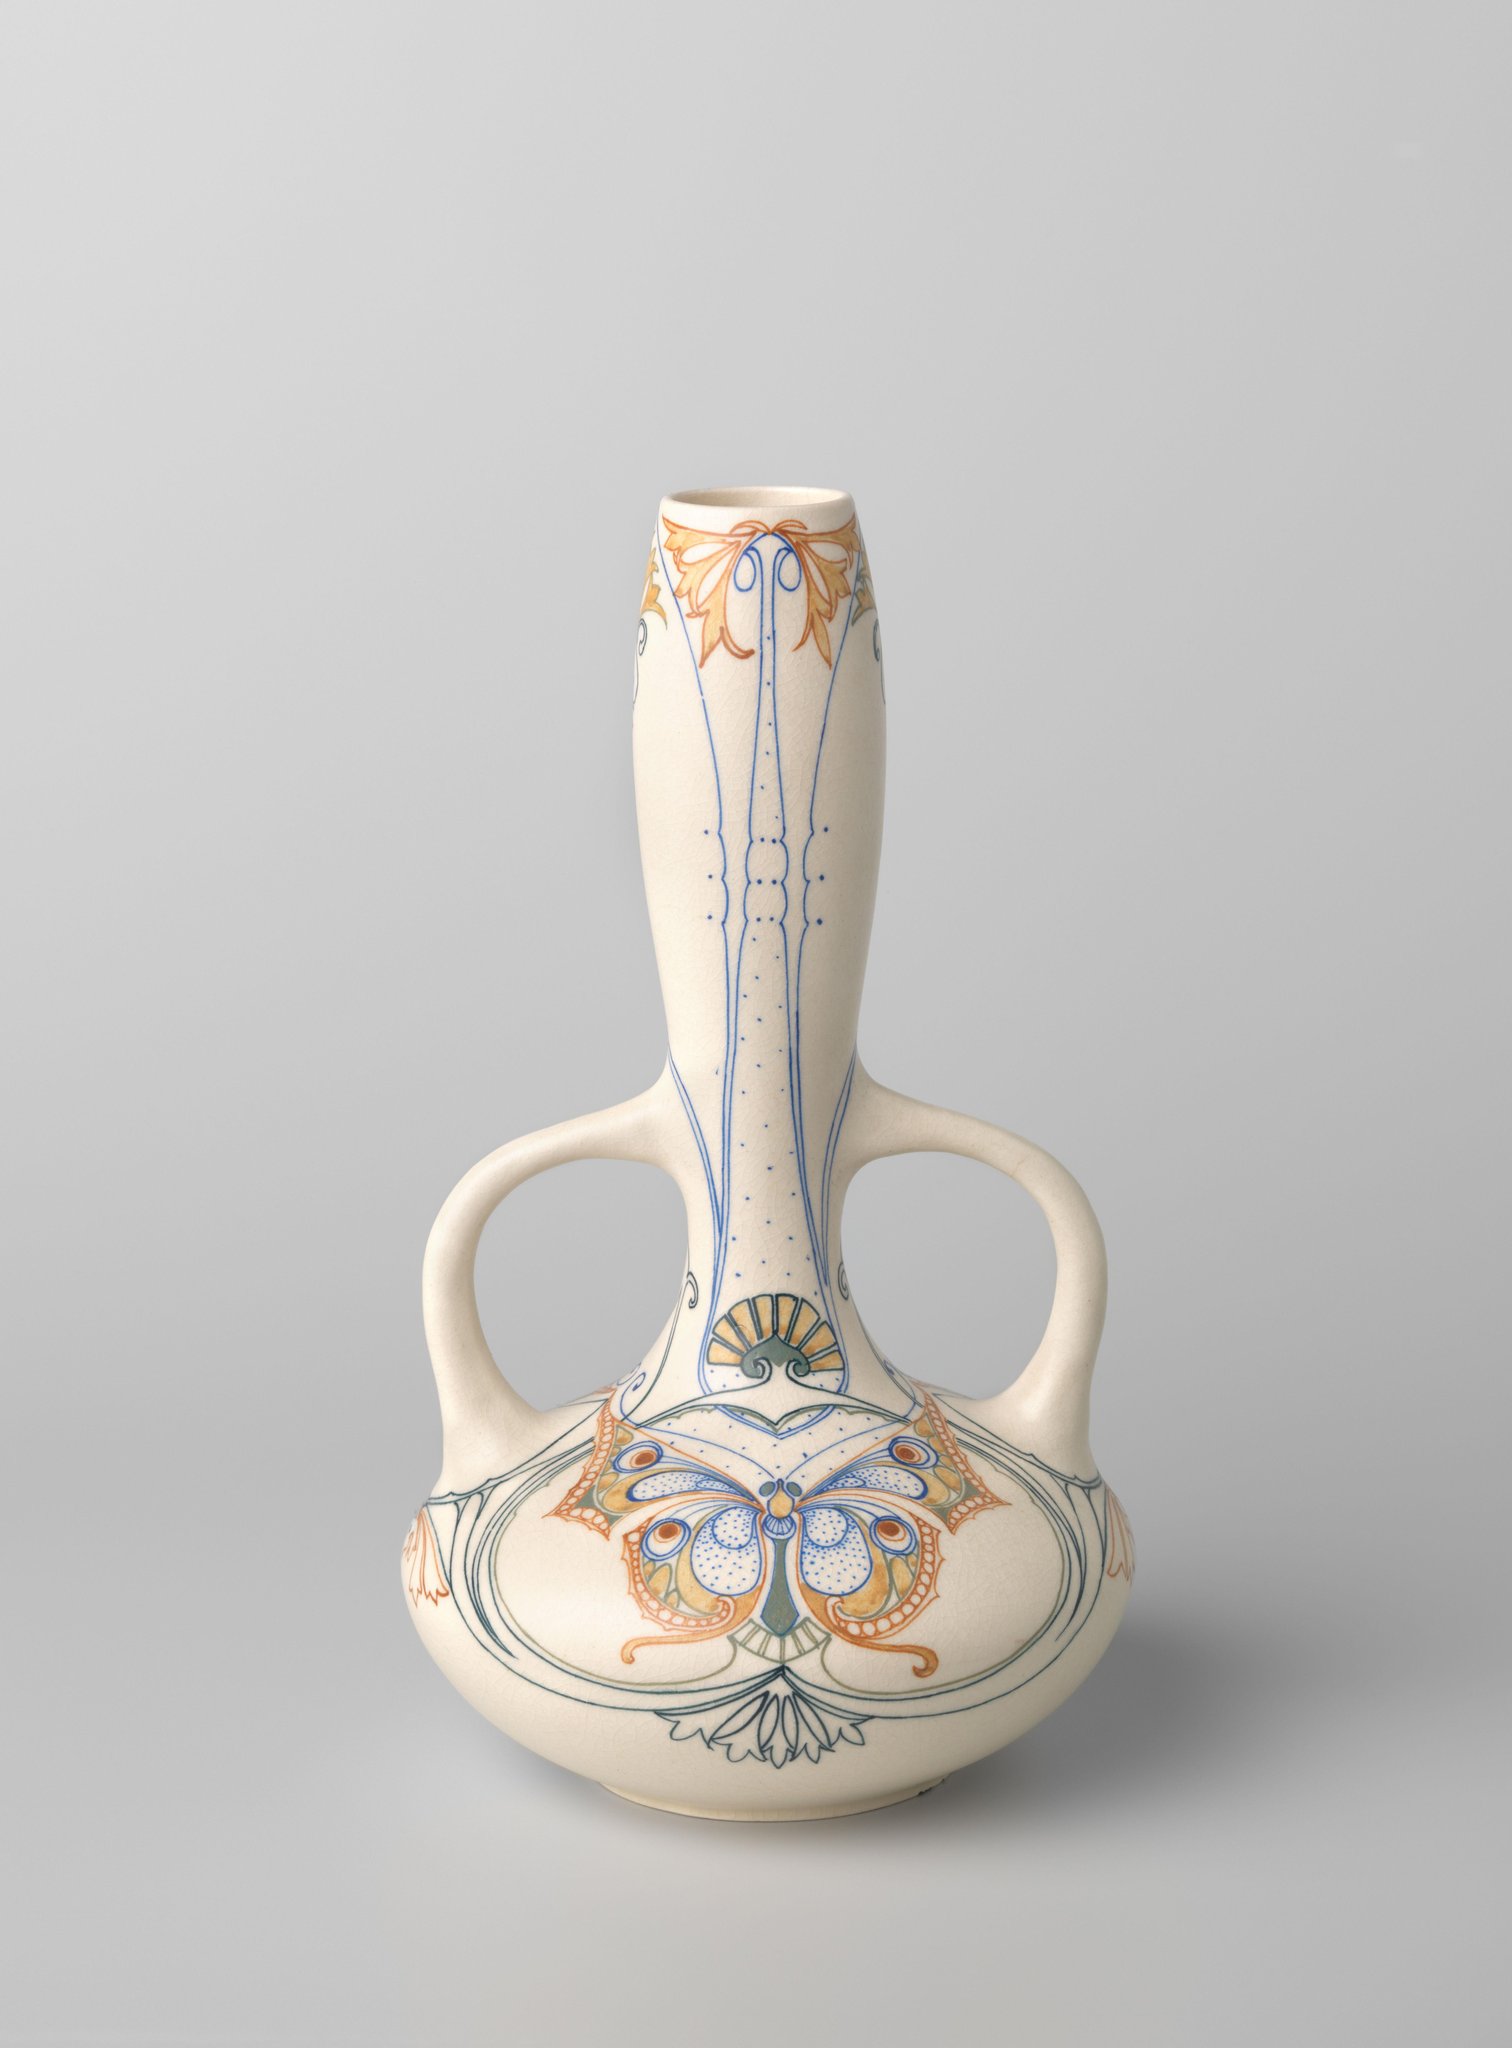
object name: vase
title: Vaas van aardewerk, beschilderd met vlinderachtige motieven, palmetten etc.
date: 1910-1915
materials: earthenware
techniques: painted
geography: arnhem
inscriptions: mark: ‘een haan en ARNHEM in schild; 95011’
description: Vaas van aardewerk, afgeplat bolvormig lichaam met lange hals en twee oren. Beschilderd in blauw, geel, groen en oranje met vlinderachtige motieven, palmetten etc. op matte gelige grond.